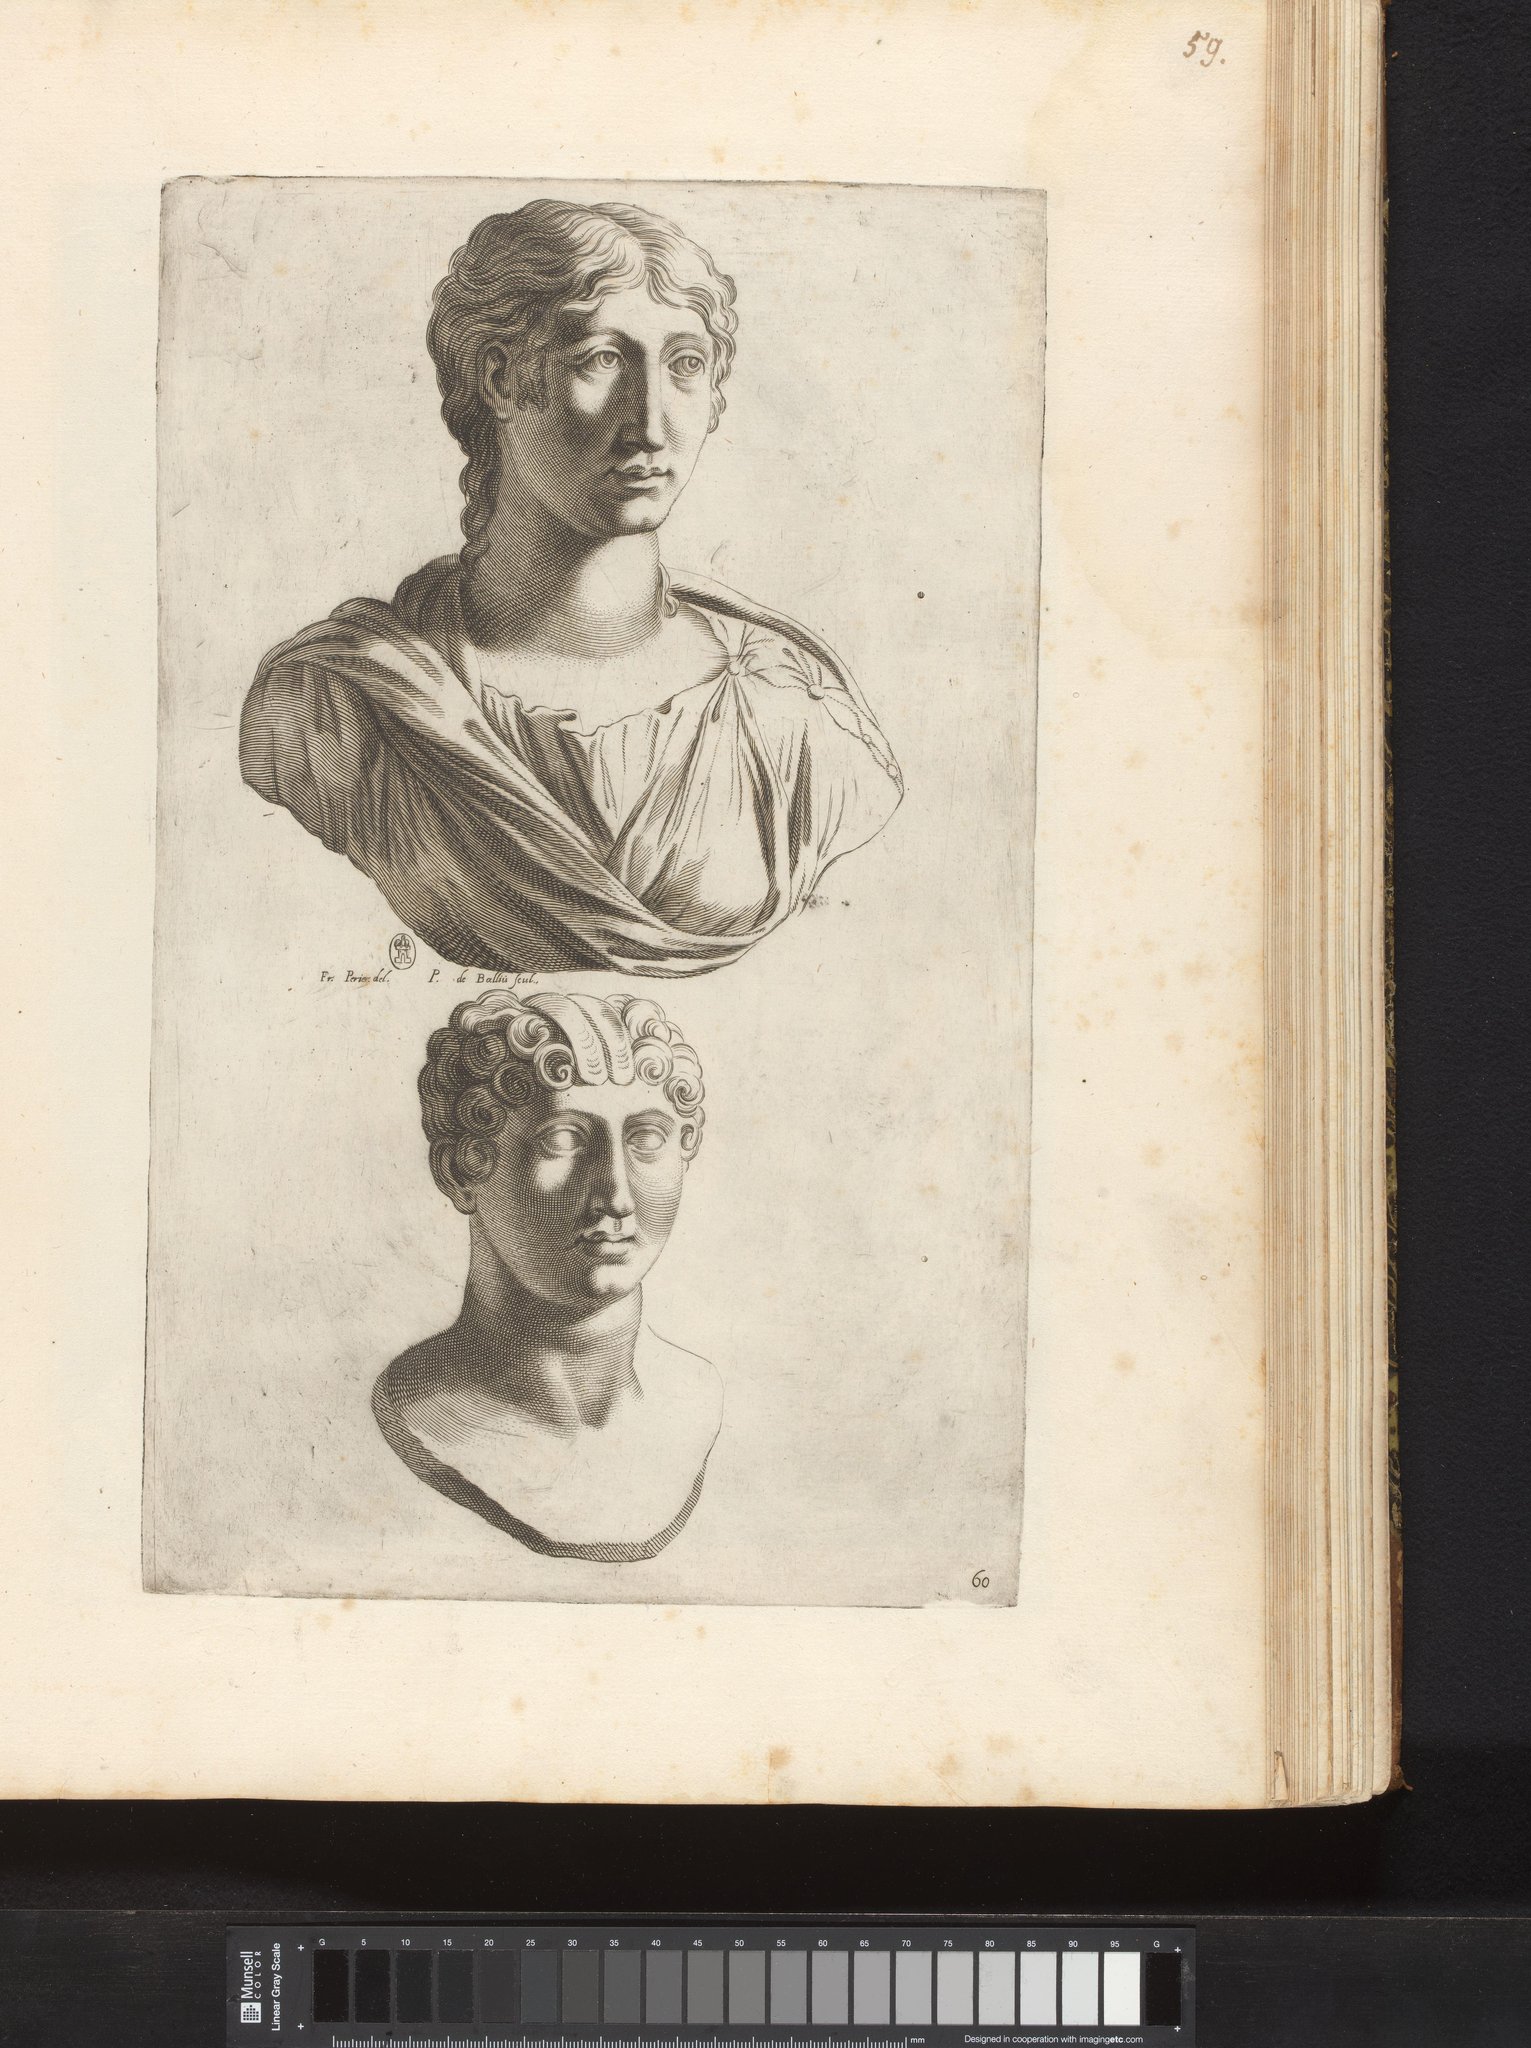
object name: album leaf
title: Galleria Giustiniana del Marchese Vincenzo Giustiniani II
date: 1636-1647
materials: paper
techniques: engraving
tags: column, pillar ~ architecture, piece of sculpture, reproduction of a piece of sculpture, sacrifice ~ non-christian religions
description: Bas-reliëf met drie figuren, die een offer brengen. Midden onder het wapenschild van Vincenzo Giustiniani, die dit bas-reliëf in zijn bezit had. Prent maakt deel uit van een album met een serie prenten naar de sculpturen in de verzameling in de Galleria Giustiniani te Rome.